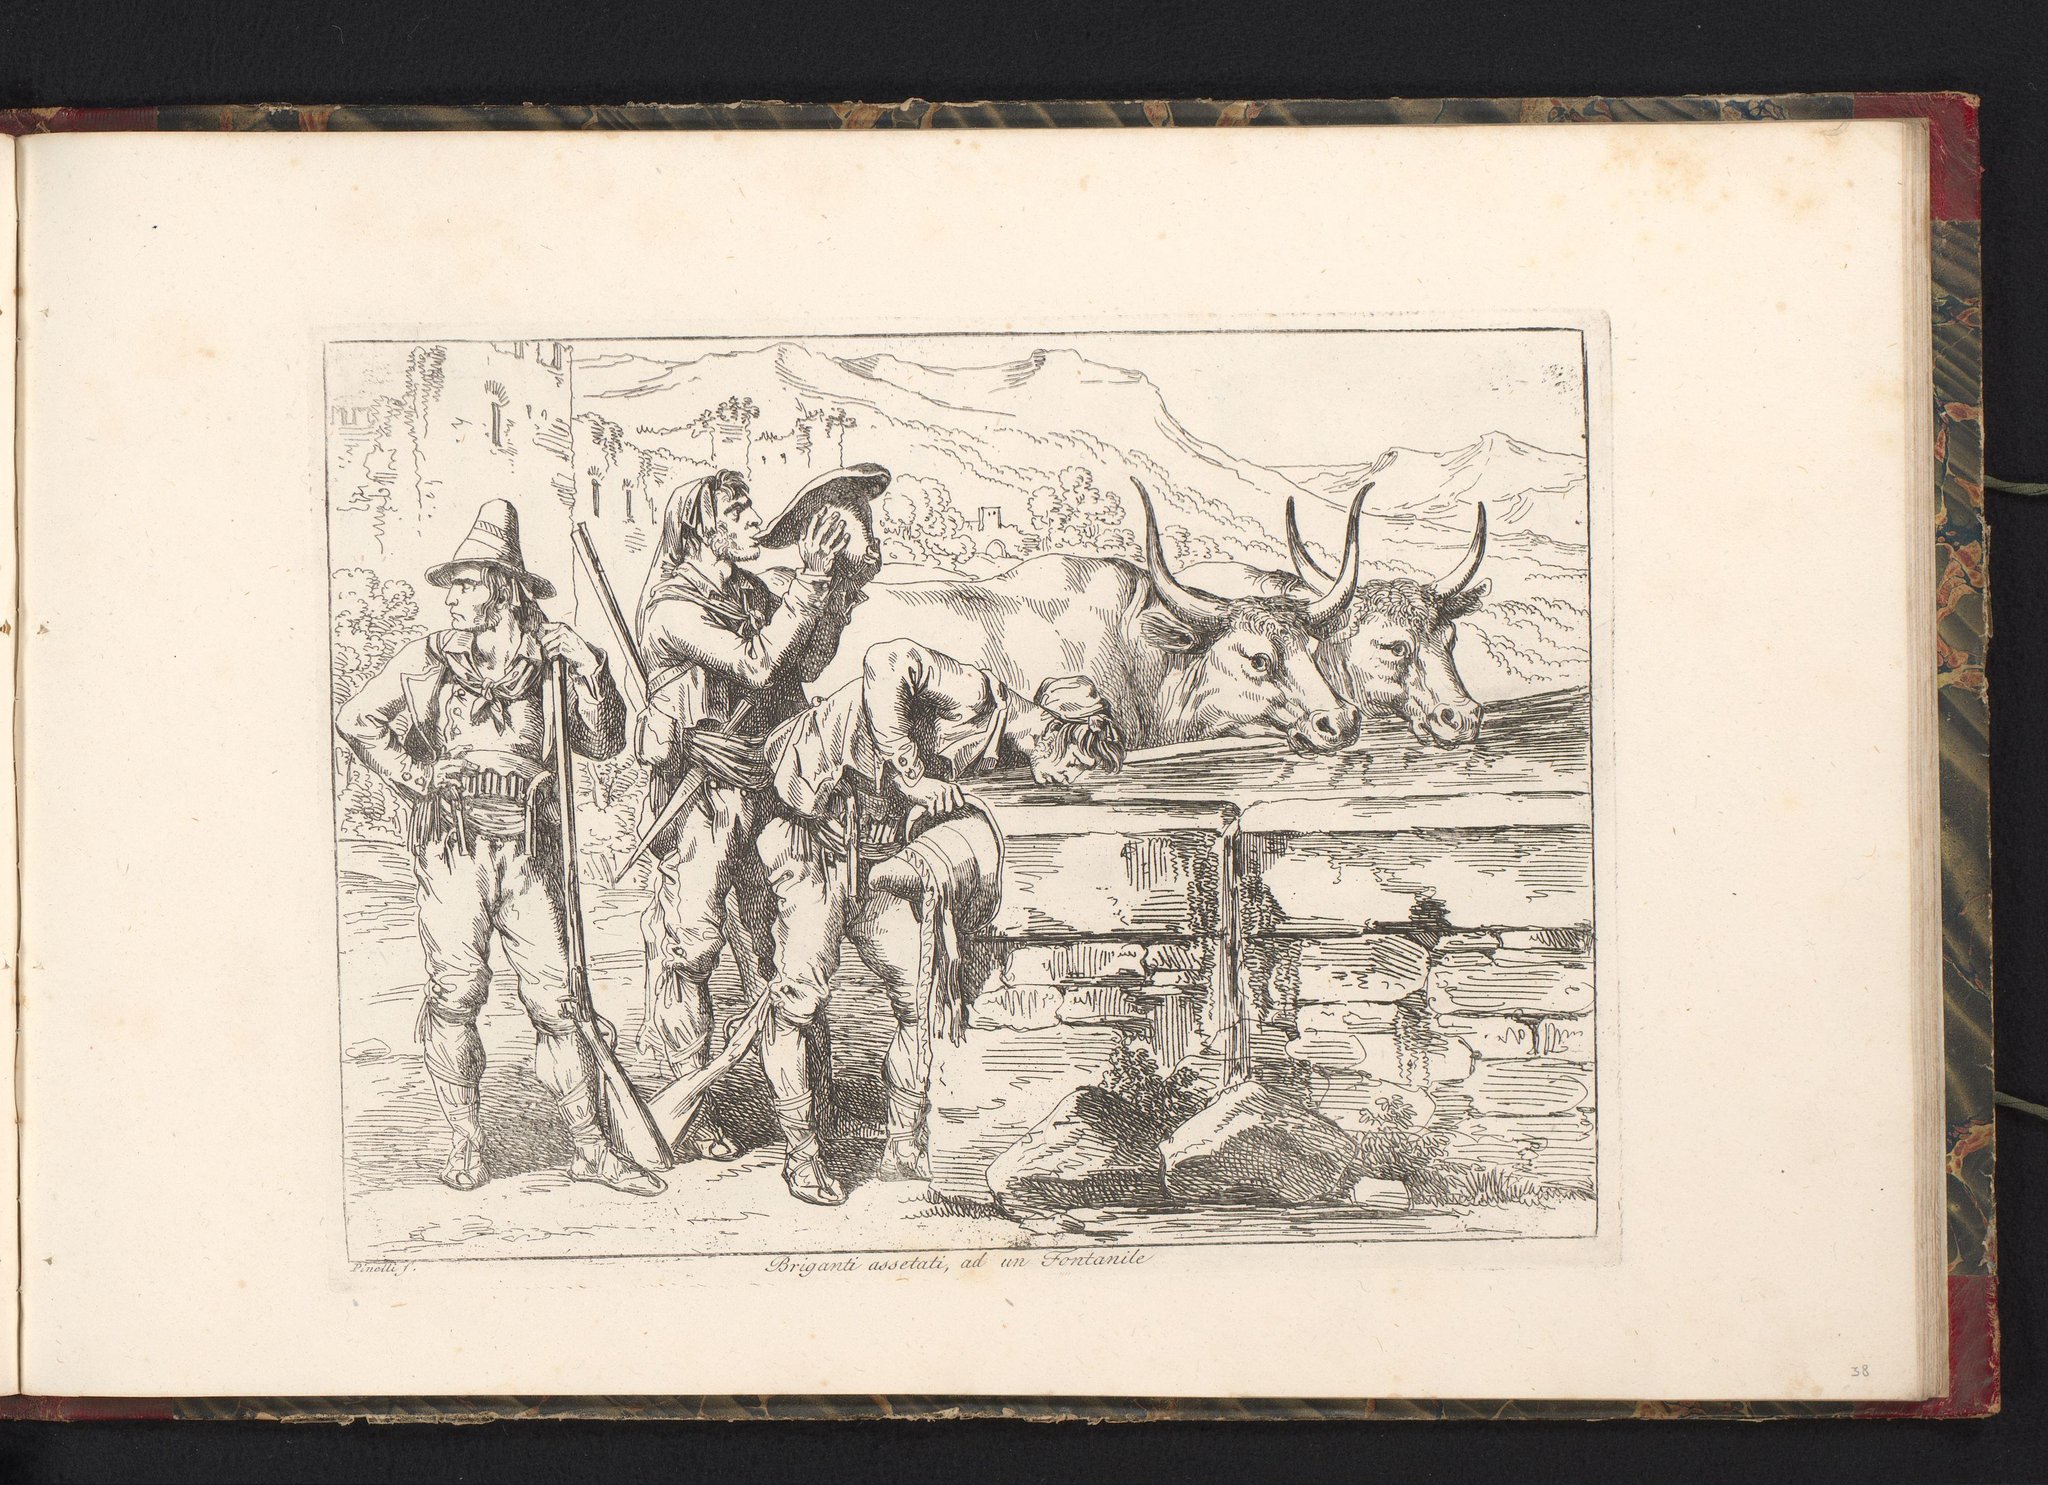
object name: print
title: Nuova raccolta di cinquanta costumi de contorni di Roma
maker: bartolomeo pinelli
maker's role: draughtsman, print maker, sculptor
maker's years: 1781-1835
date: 1819-1823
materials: paper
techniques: etching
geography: rome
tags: city-view, and landscape with man-made constructions, robber, folk costume, regional costume, giving water, feeding (cattle), drinking, mountains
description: Drie bandieten bij een waterput. Eén van hen drinkt uit de put, terwijl een ander zijn hoed gebruikt om uit te drinken. Twee stieren drinken ook uit de put. Op de achtergrond een bergachtig landschap. De prent maakt deel uit van een album.